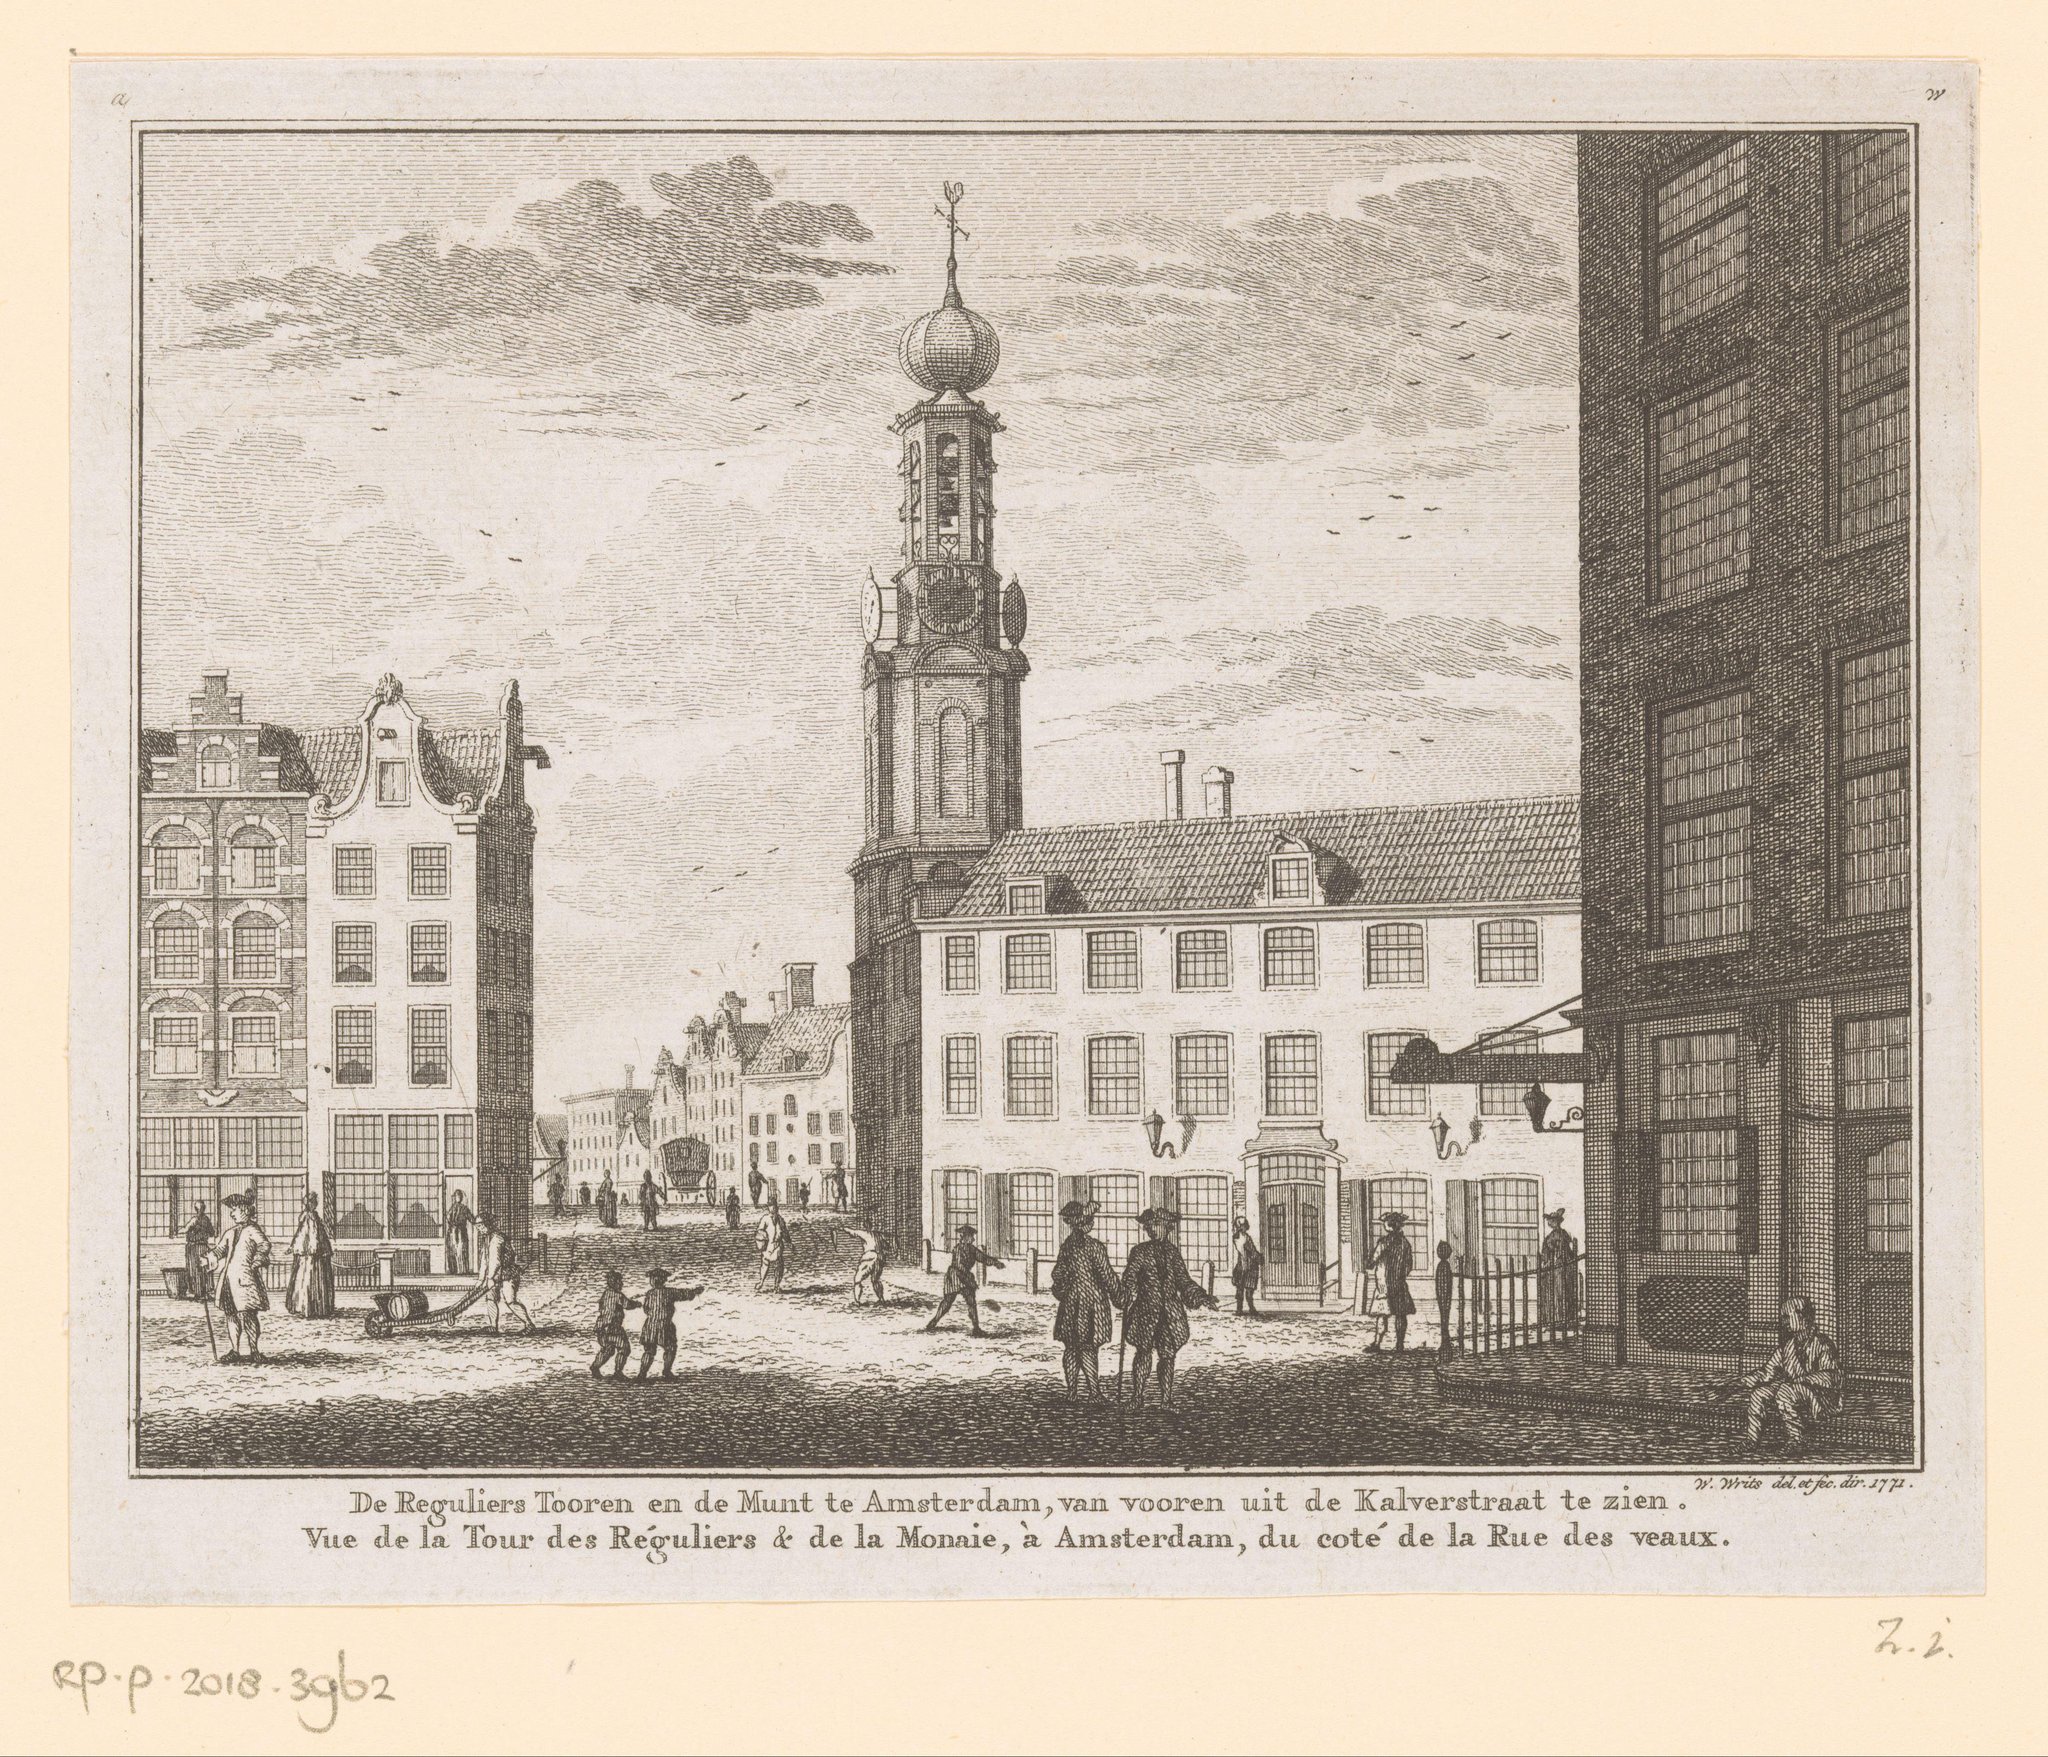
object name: print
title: Gezicht op de Munttoren te Amsterdam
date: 1804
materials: paper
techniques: etching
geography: amsterdam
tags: tower, clock tower ~ monumental adornment, rowing-boat, canoe, etc., minter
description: Prent uit: Elwe, Jan Barend. Atlas van de wereldberoemde koopstad Amsteldam (...). Amsterdam: Jan Barend Elwe, 1804. De Regulierstoren is tegenwoordig bekend als de Munttoren.